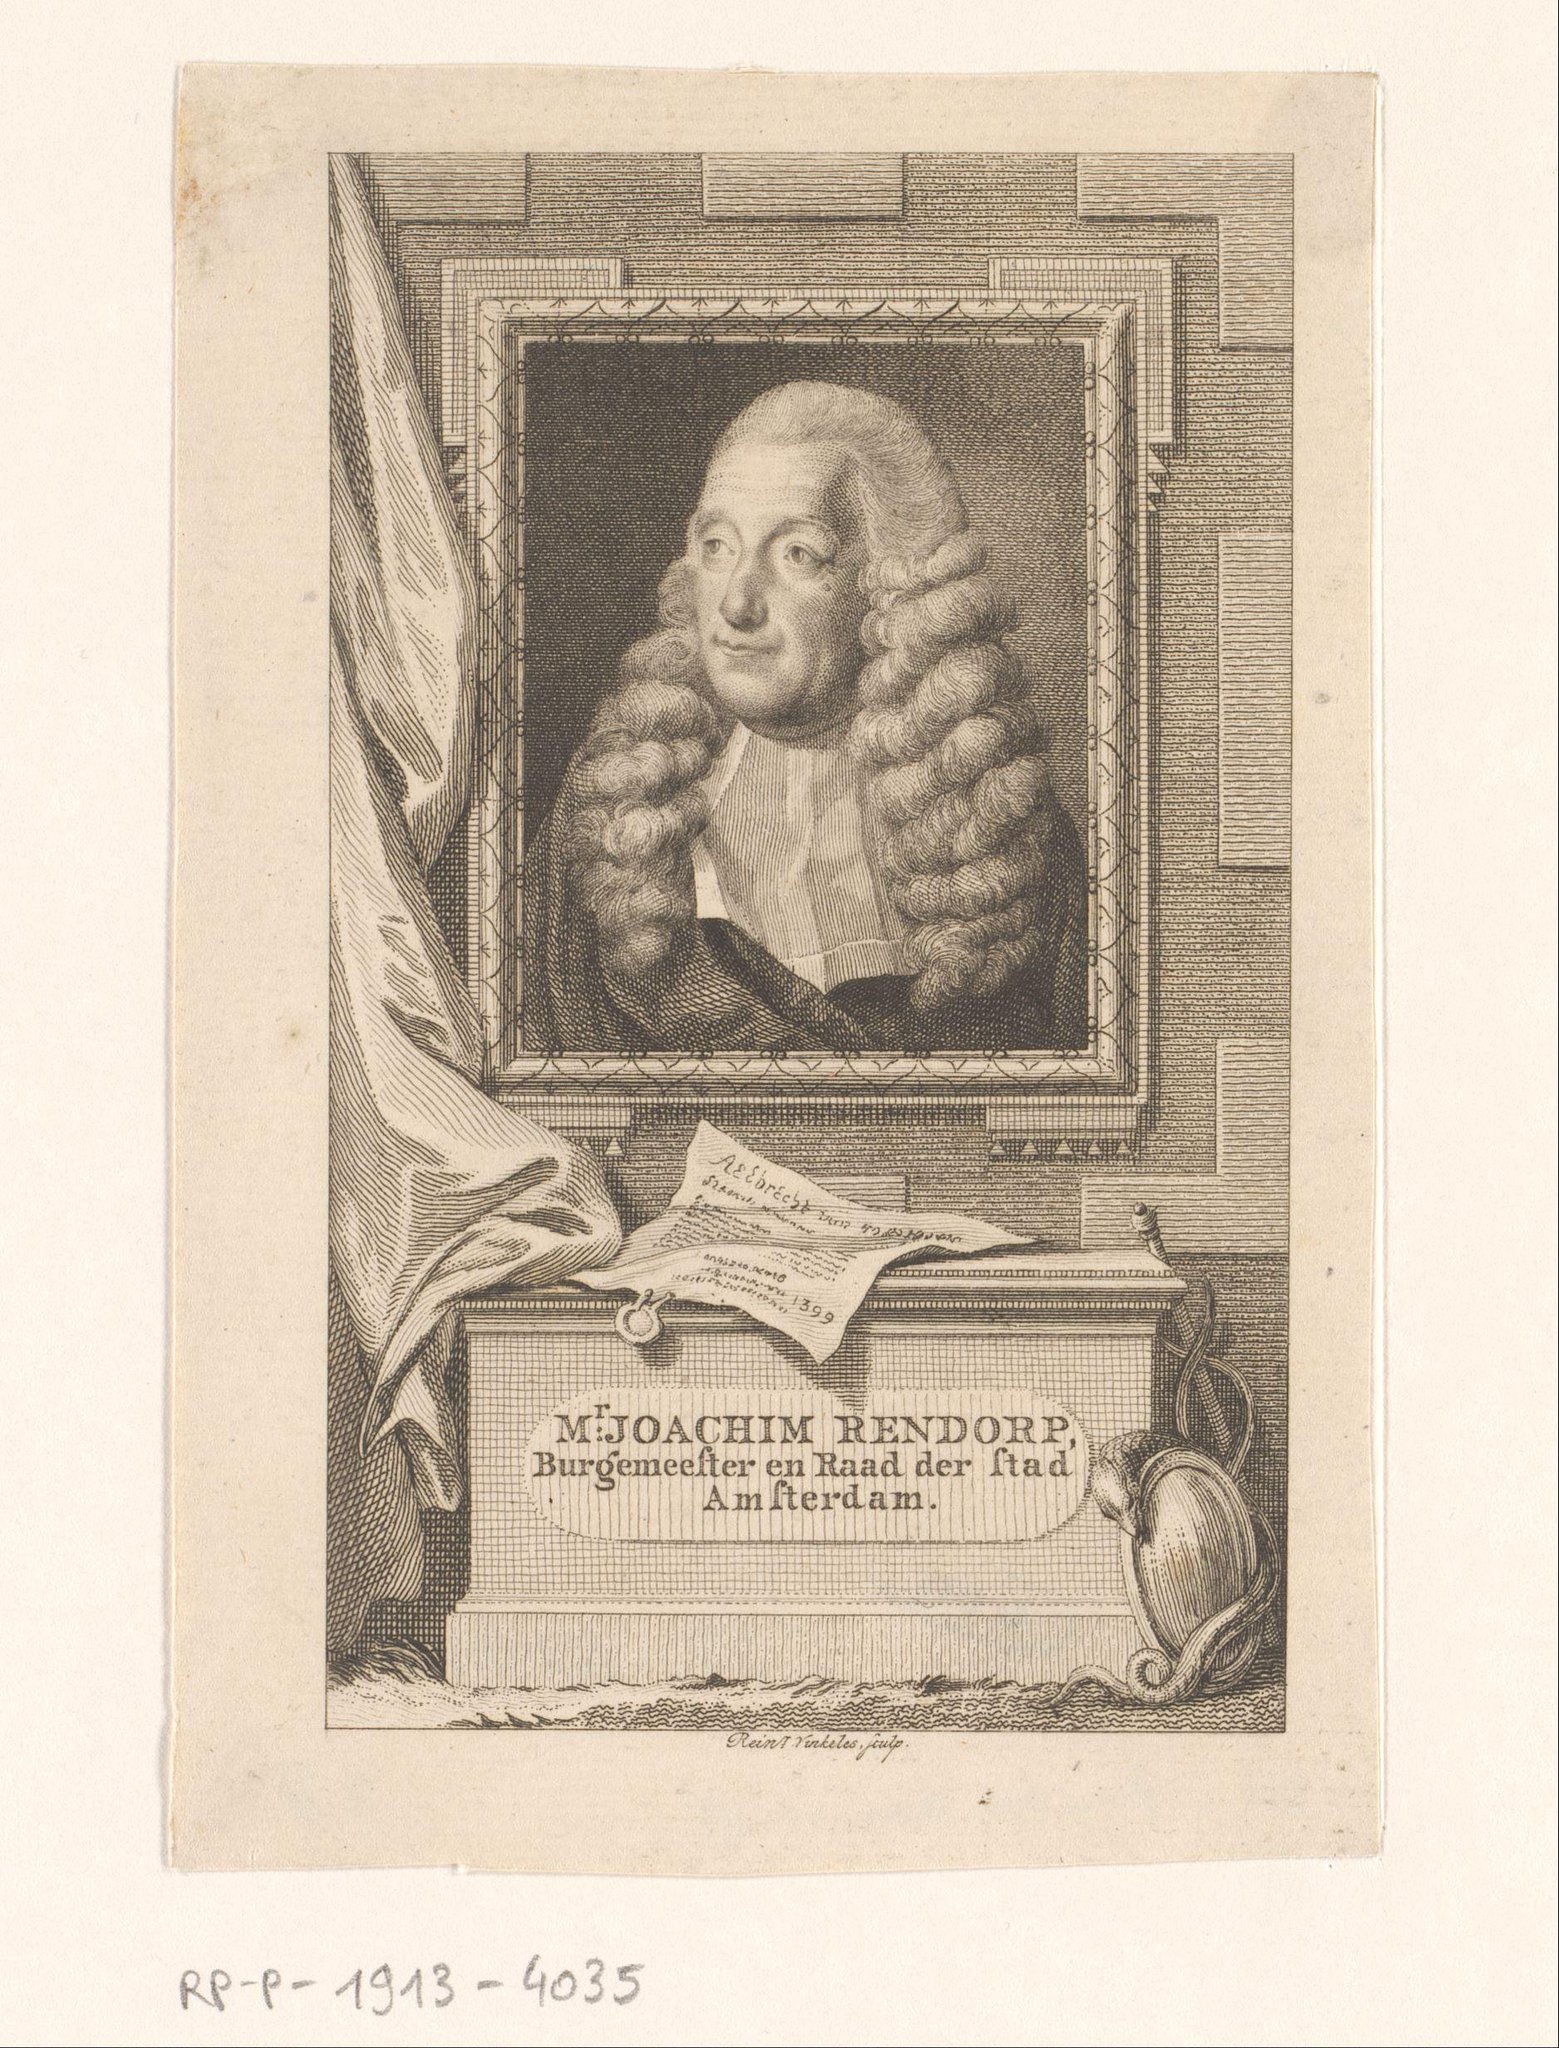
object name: book illustration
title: Portret van Joachim Rendorp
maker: reinier vinkeles (i)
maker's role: draughtsman, print maker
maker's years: 1741-1816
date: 1800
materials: paper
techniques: etching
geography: amsterdam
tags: joachim rendorp, mayor, burgomaster, historical persons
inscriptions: collector's mark: Lugt 2228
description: Portret van de Amsterdamse burgemeester Joachim Rendorp. Onder het portret een document uit 1399 van Albrecht van Beieren, rechts een met een slang omkronkelde spiegel, symbool voor voorzichtigheid.